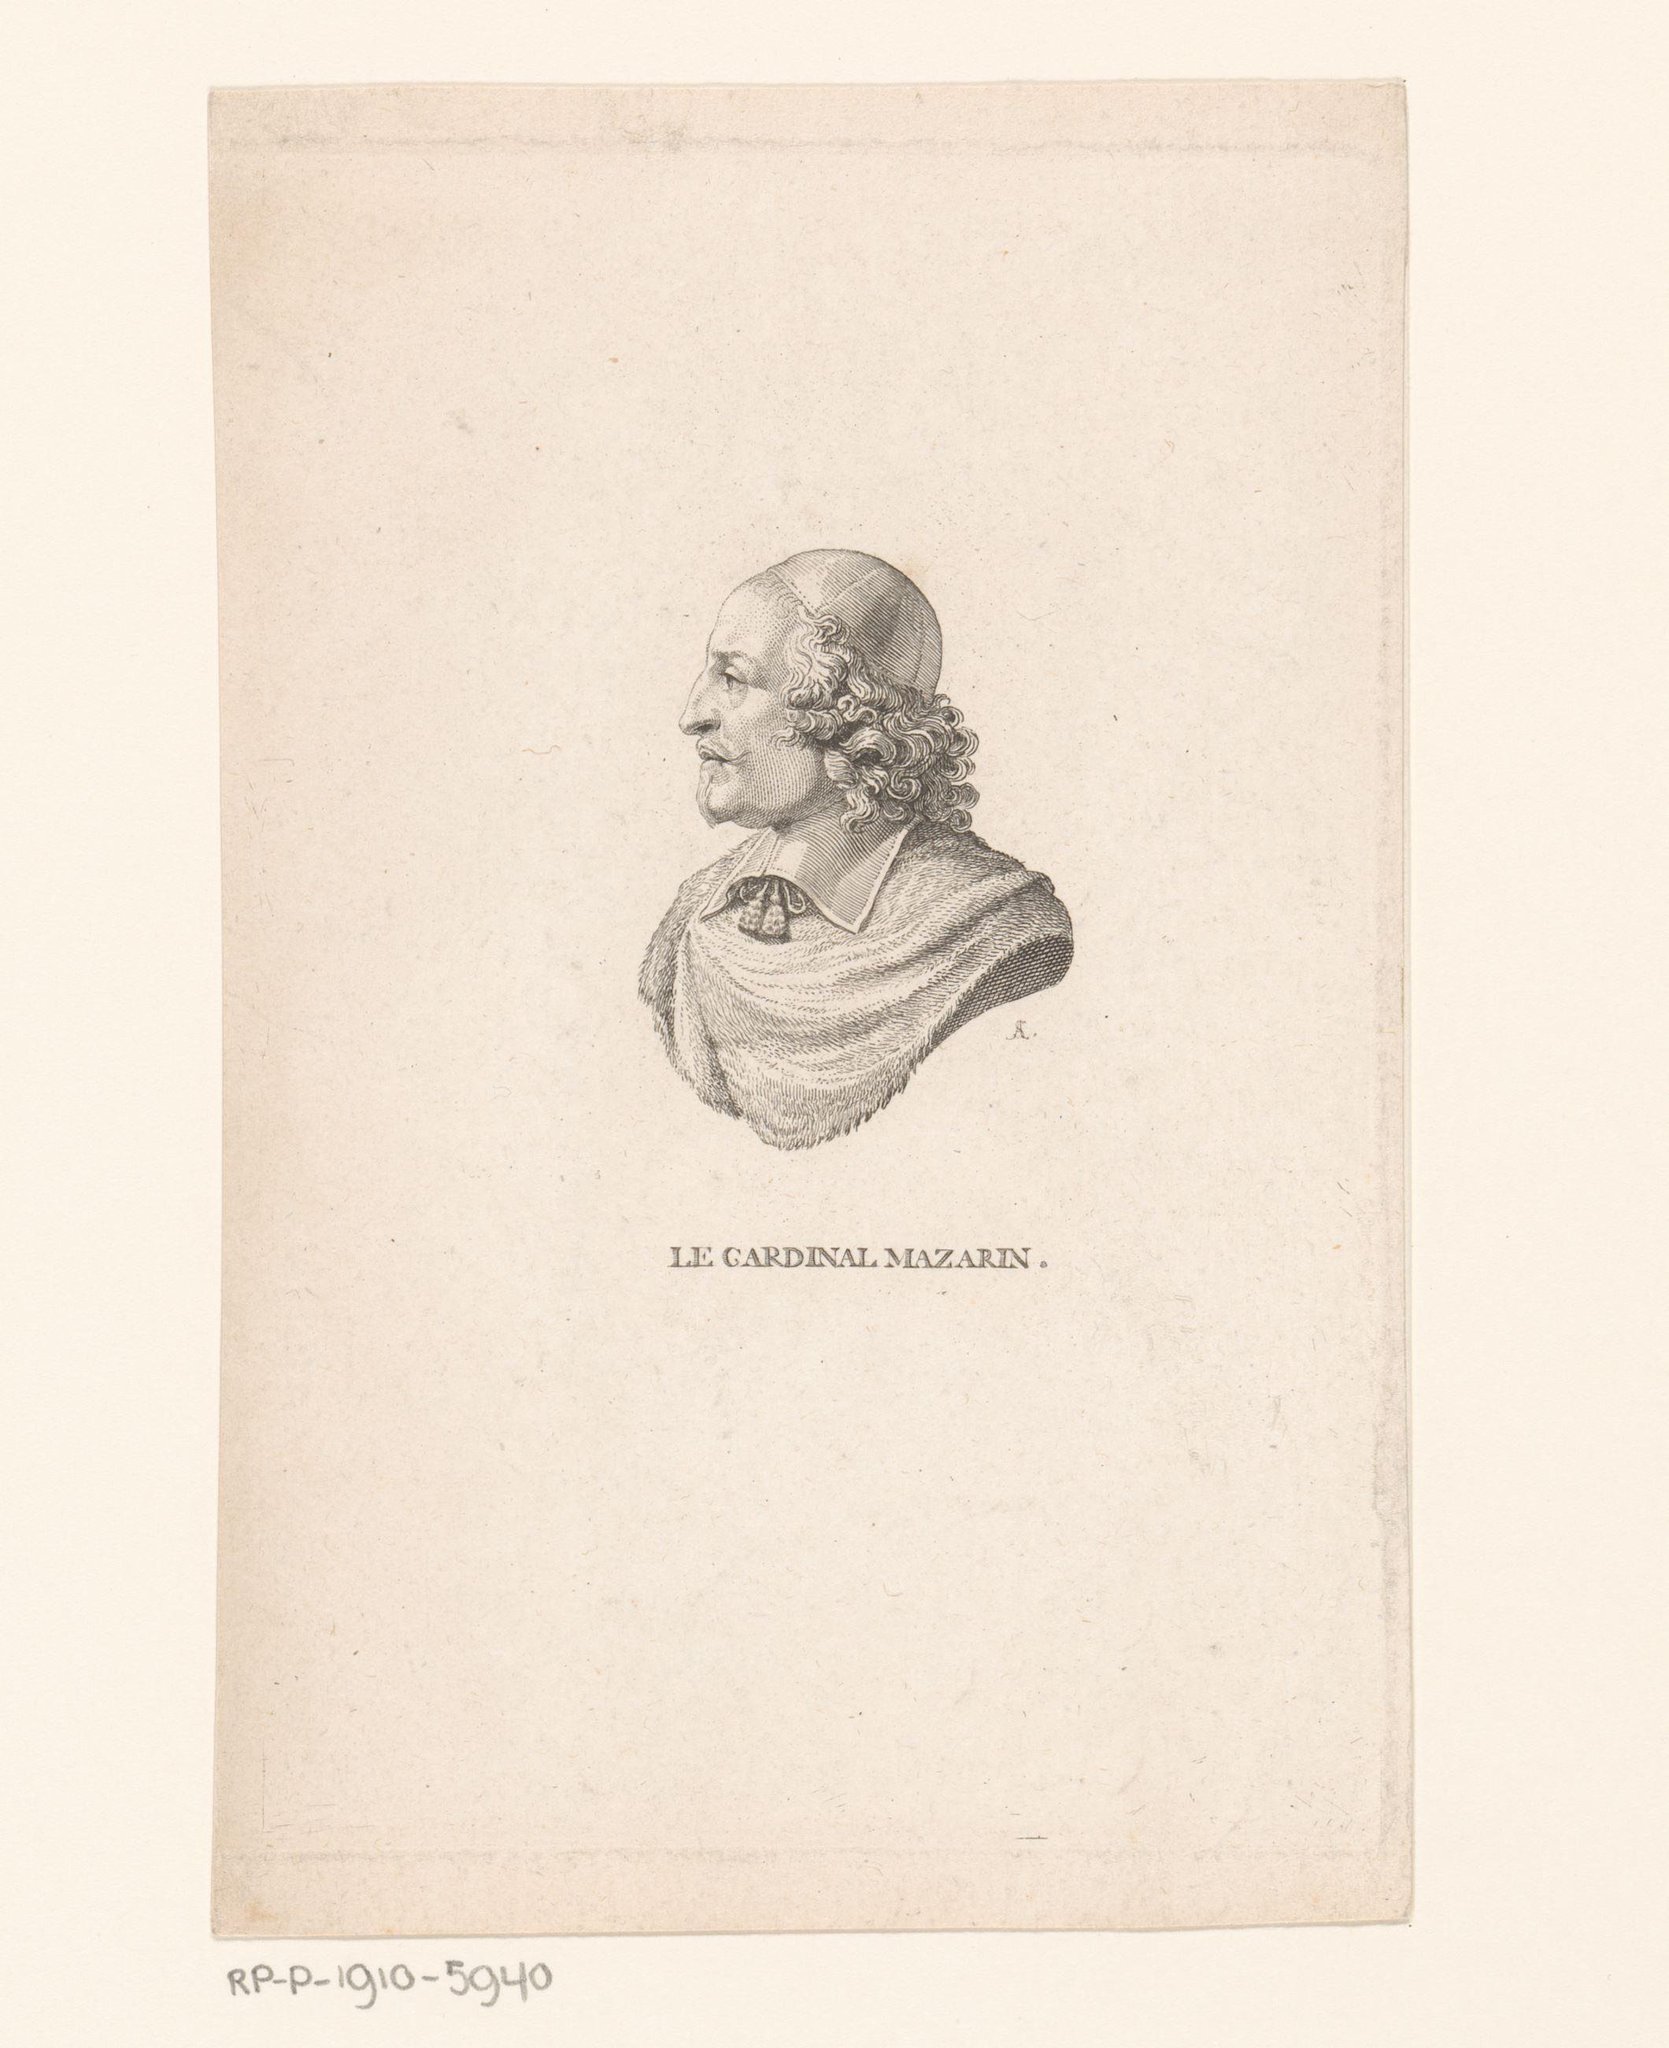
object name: print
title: Portret van kardinaal Mazarin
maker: augustin de saint-aubin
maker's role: draughtsman, print maker, publisher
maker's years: 1736-1807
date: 1804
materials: paper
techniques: engraving, etching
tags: jules mazarin, cardinal, historical persons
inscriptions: collector's mark: Lugt 2228